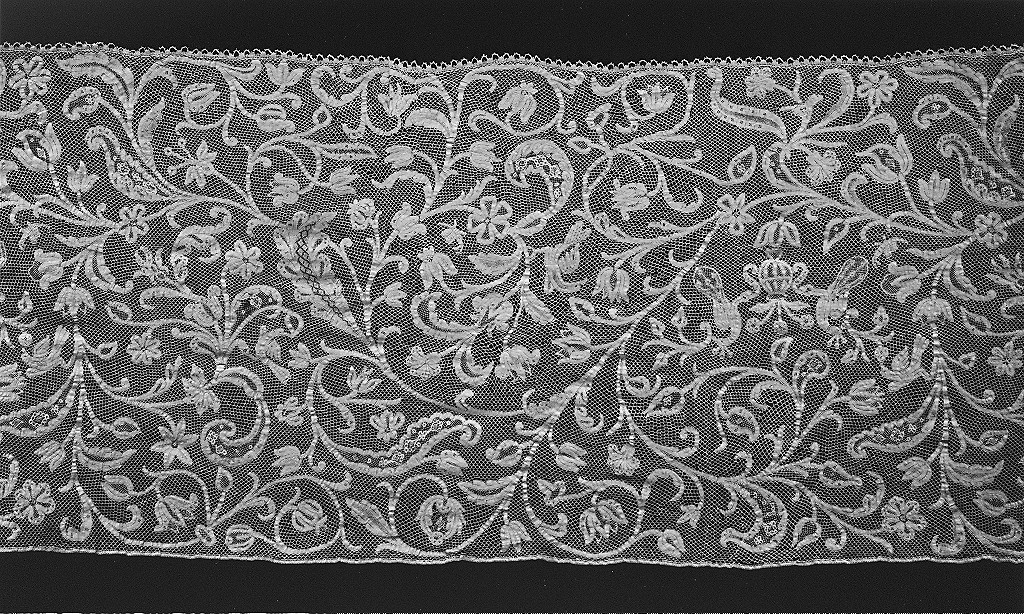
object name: border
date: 1701-1733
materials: lace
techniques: lace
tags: flowers